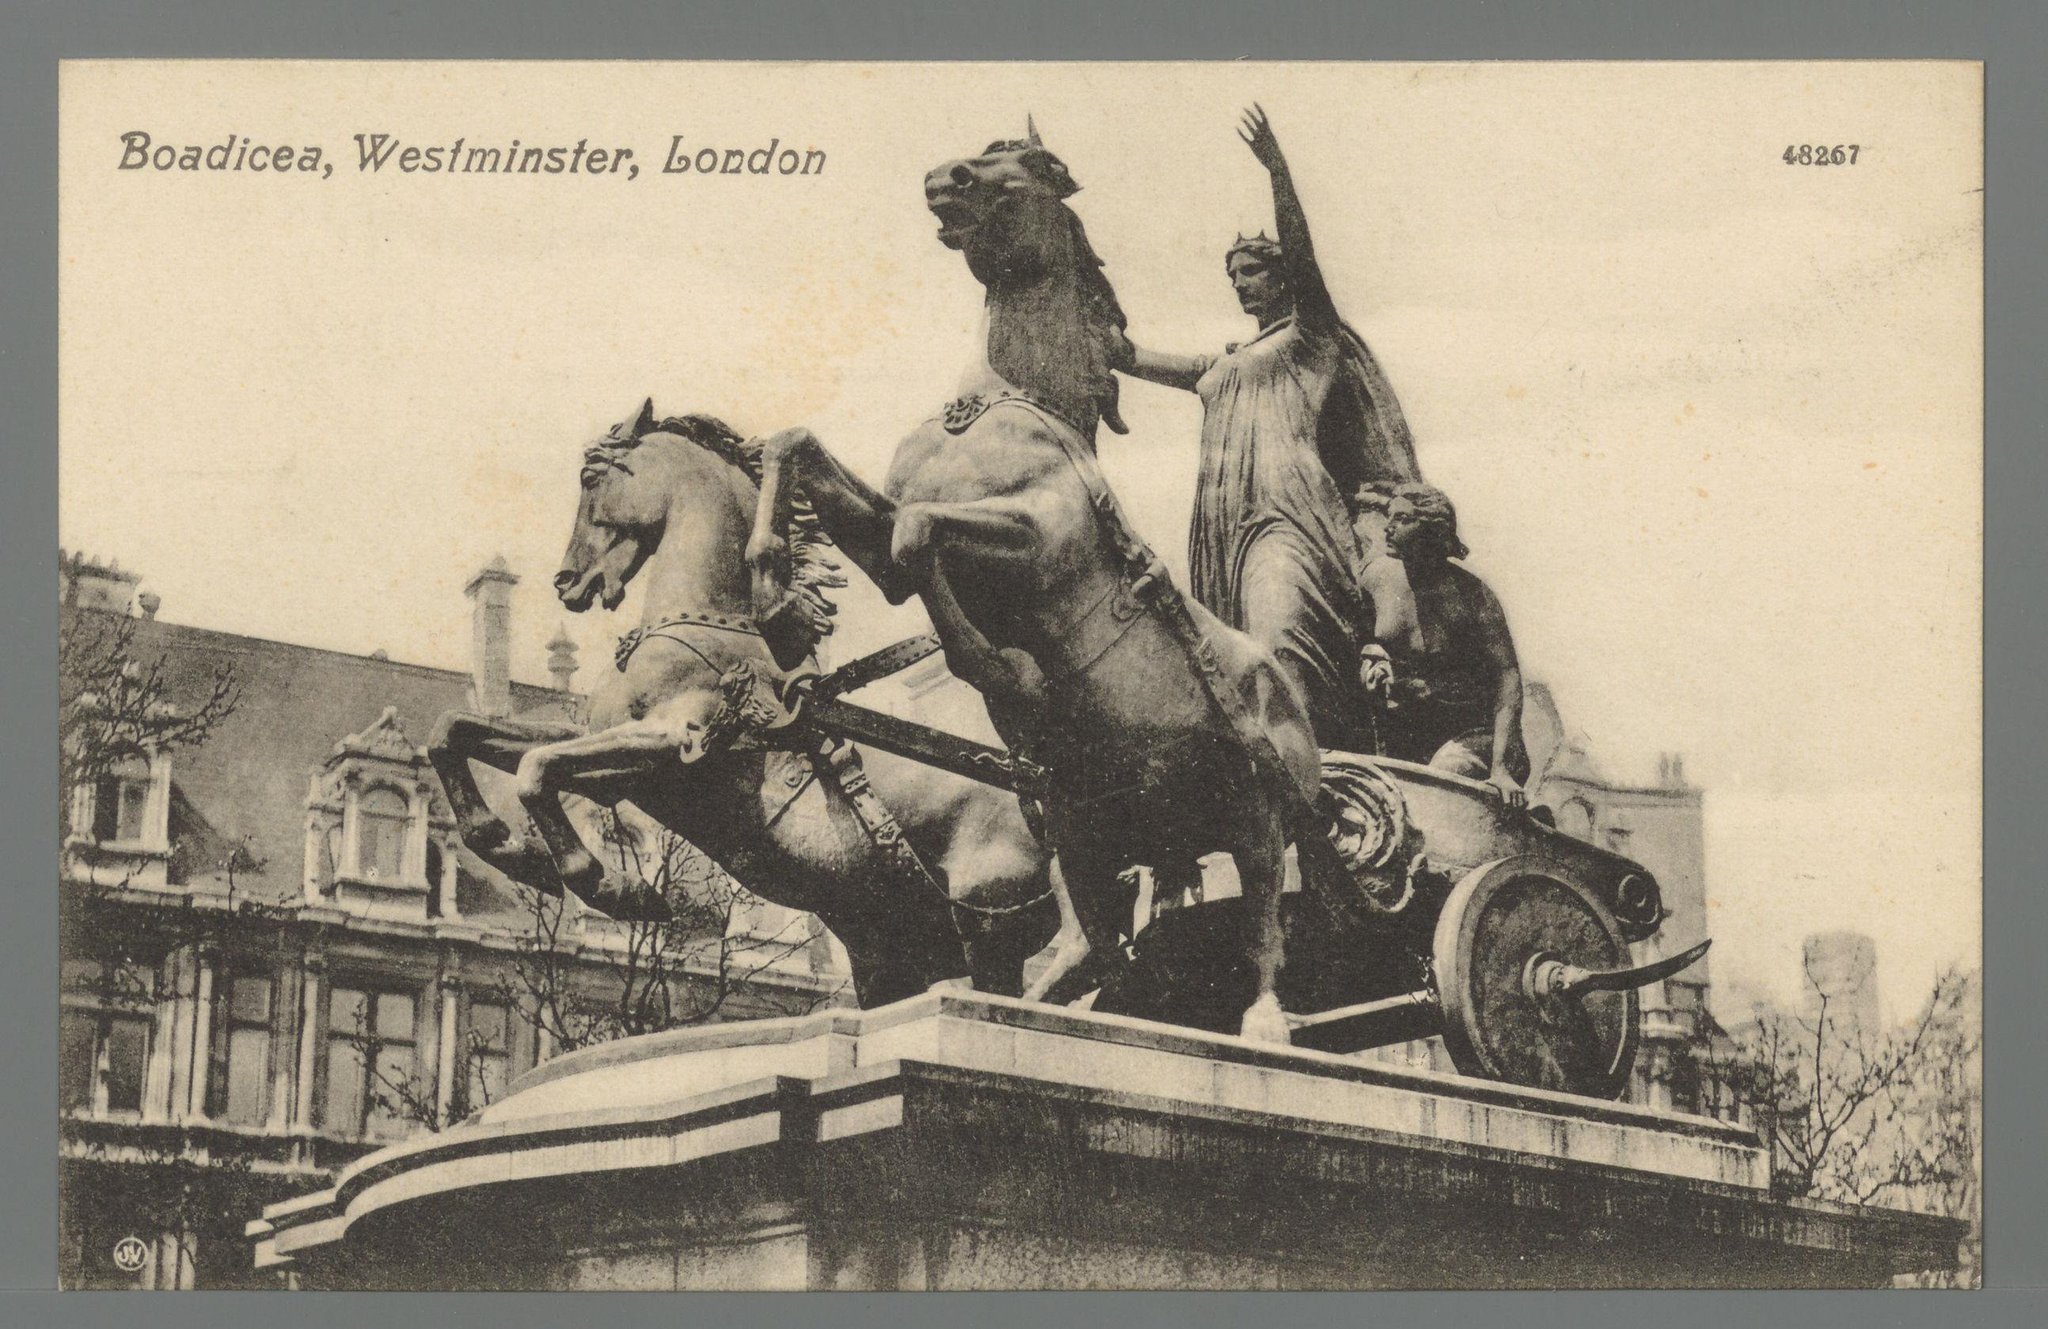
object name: ansichtkaart, prentbriefkaart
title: Boadicea, Westminster, London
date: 1902-1930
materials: cardboard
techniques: photograph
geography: dundee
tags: ancient forms of military vehicles: chariot, battle wagon, etc., monument, statue